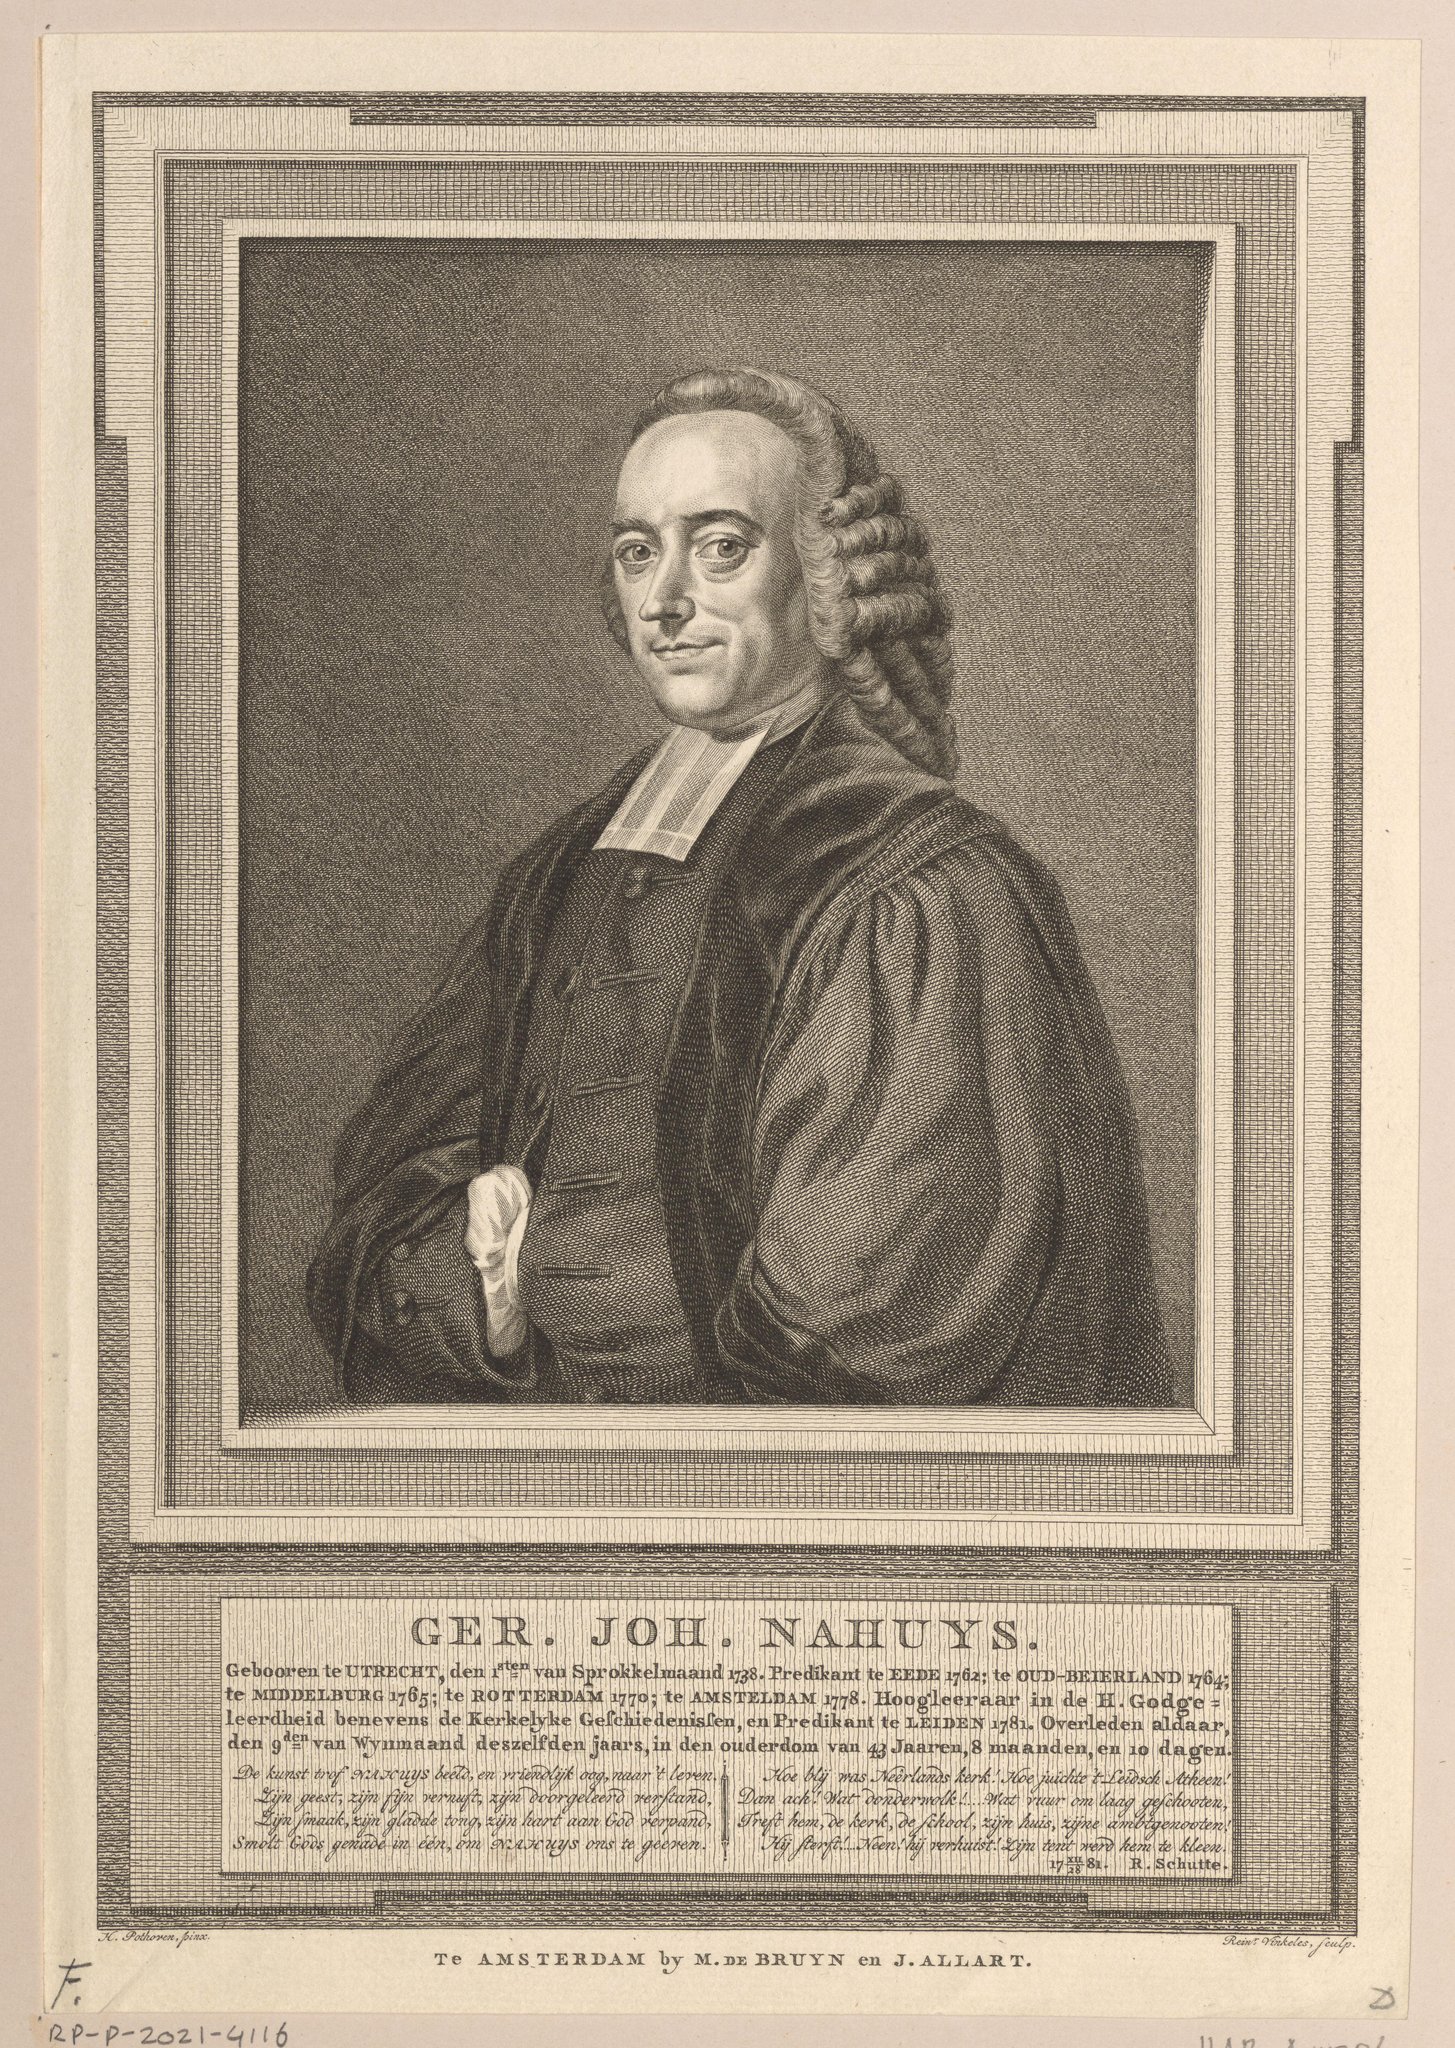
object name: print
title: Portret van Gerard Johan Nahuys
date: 1772-1816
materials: paper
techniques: engraving, etching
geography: amsterdam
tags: utrecht, theologian, historical persons, professor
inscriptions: collector's mark: Lugt 240